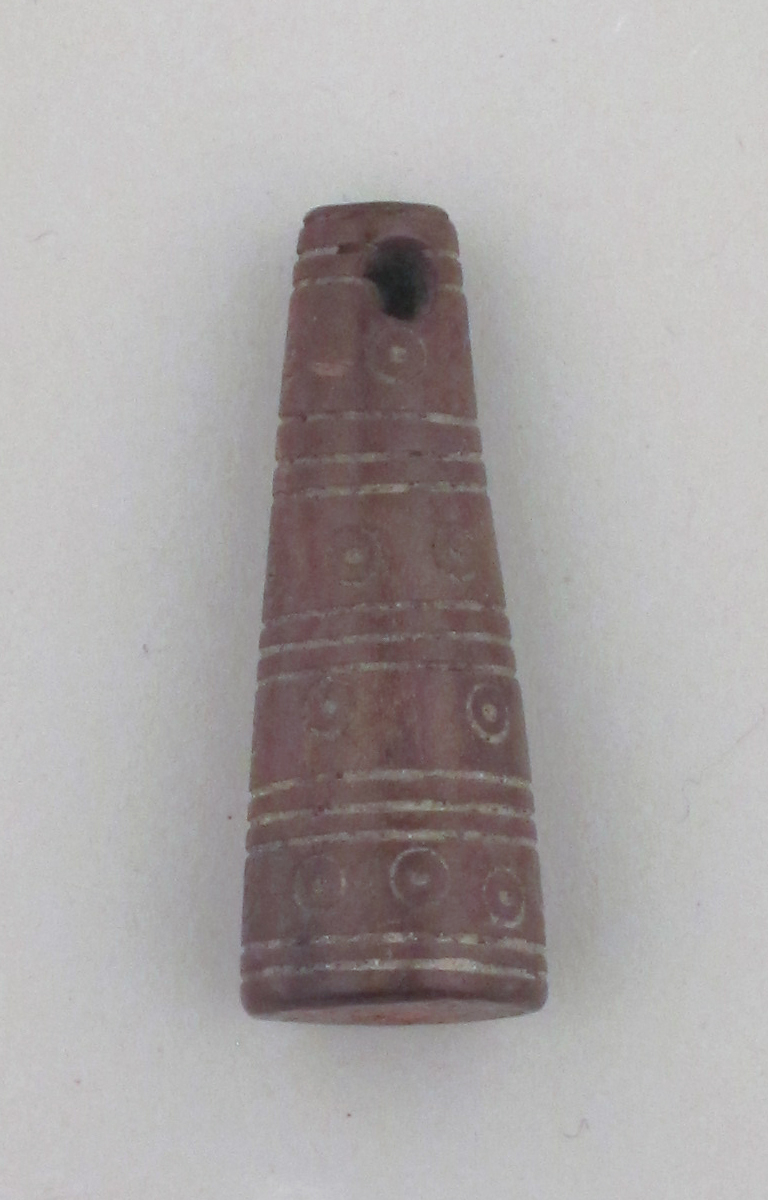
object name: plumbline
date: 7000 BCE-330 CE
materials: bone, ivory